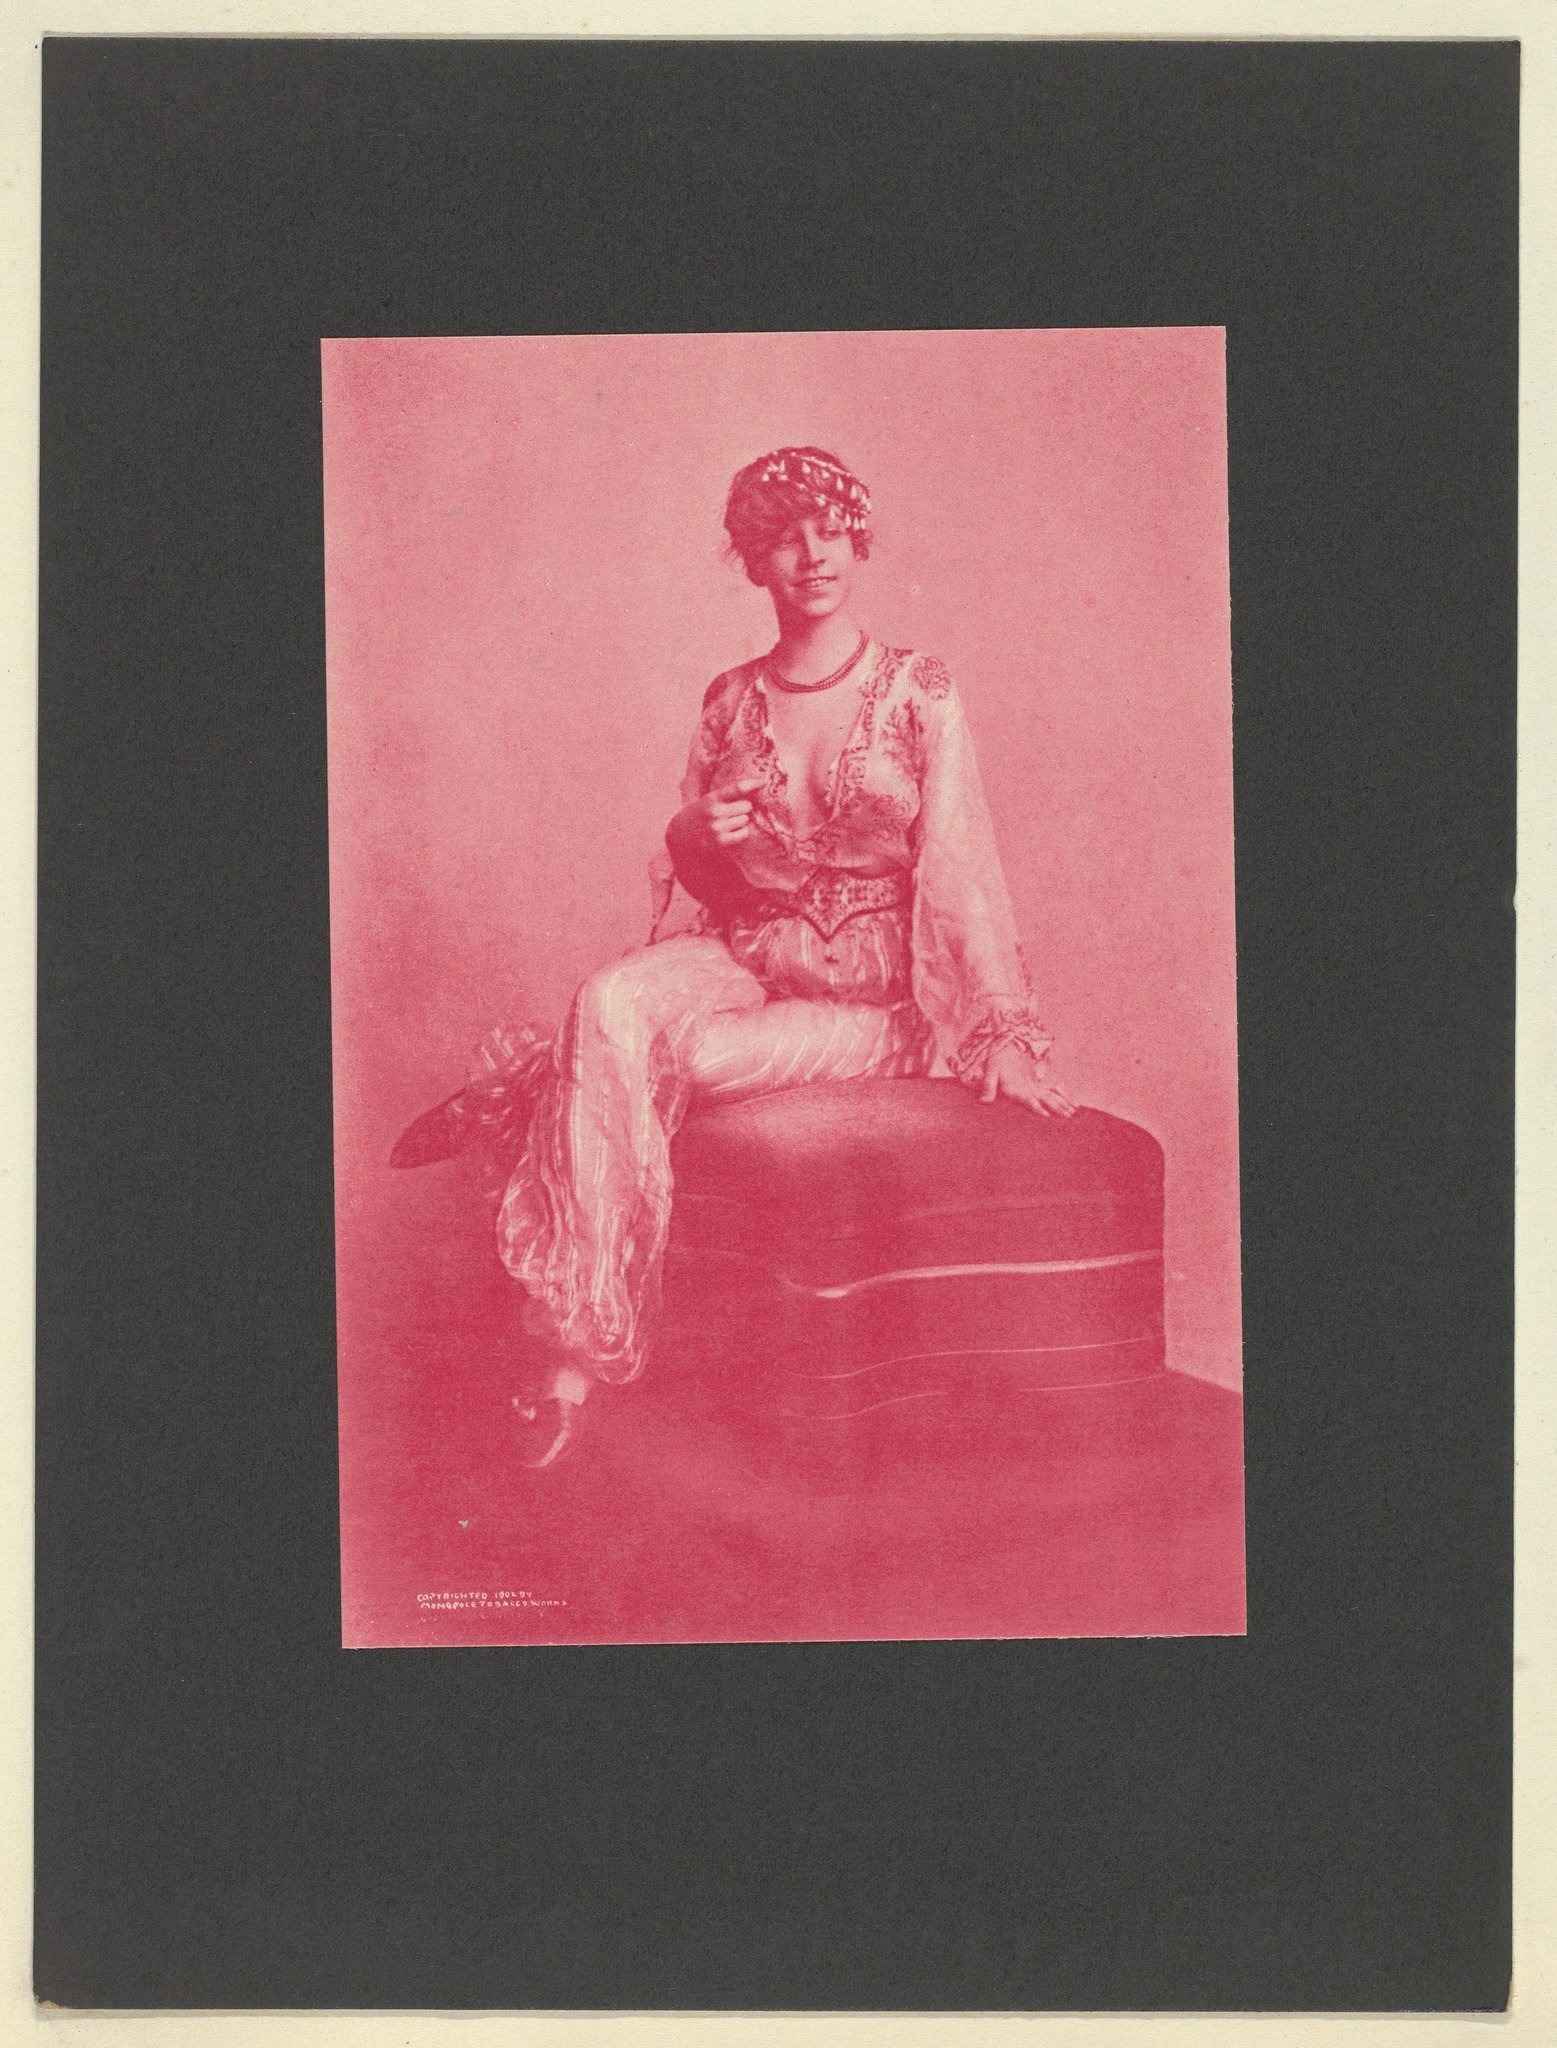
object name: print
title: Plate 11, from Little Egypt Actresses series (T2), issued by Monopole Tobacco Works to promote Khedive Egyptian Cigarettes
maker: monopole tobacco works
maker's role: publisher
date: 1902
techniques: photolithograph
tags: portraits,women,actresses